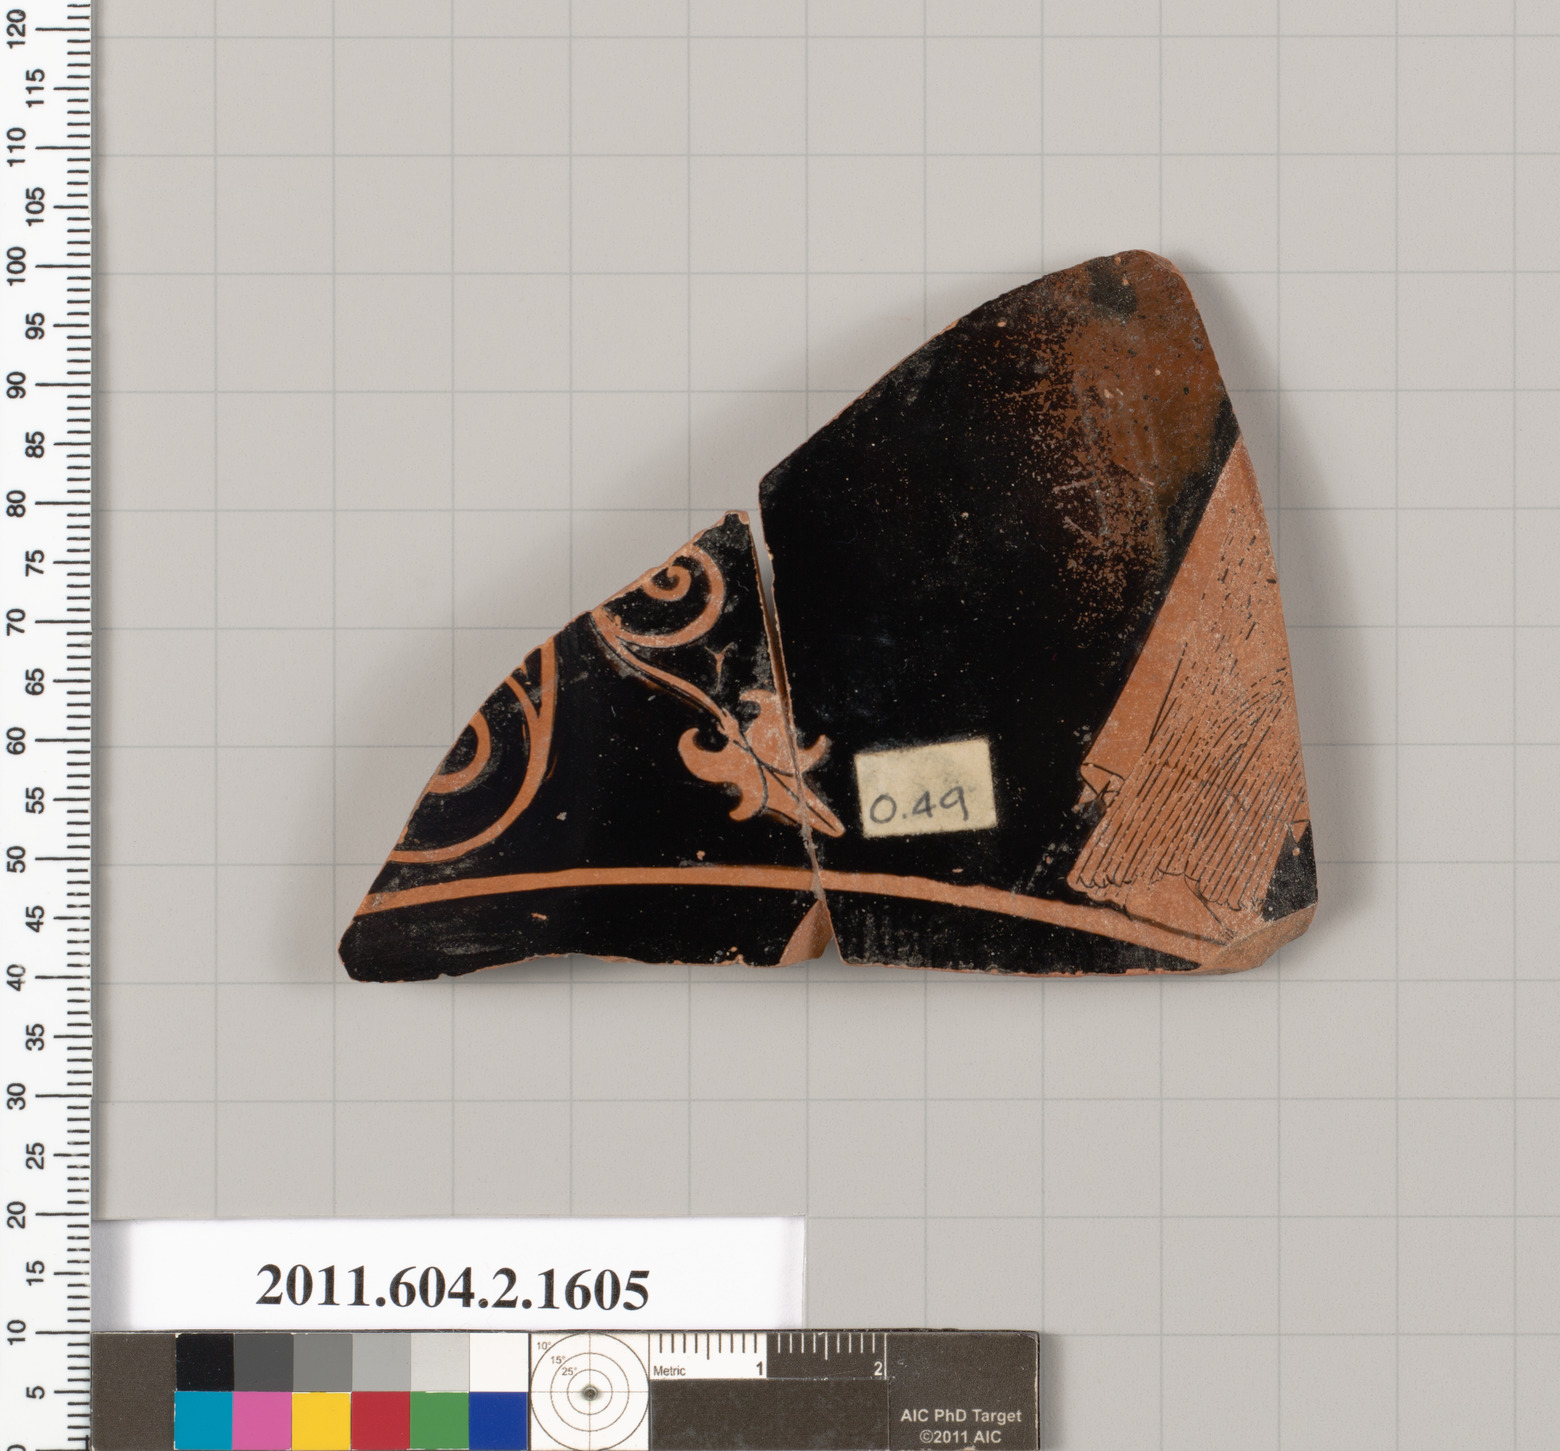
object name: skyphos fragment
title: Terracotta fragment of a skyphos (deep drinking cup)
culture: greek, attic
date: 475-451 BCE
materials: terracotta